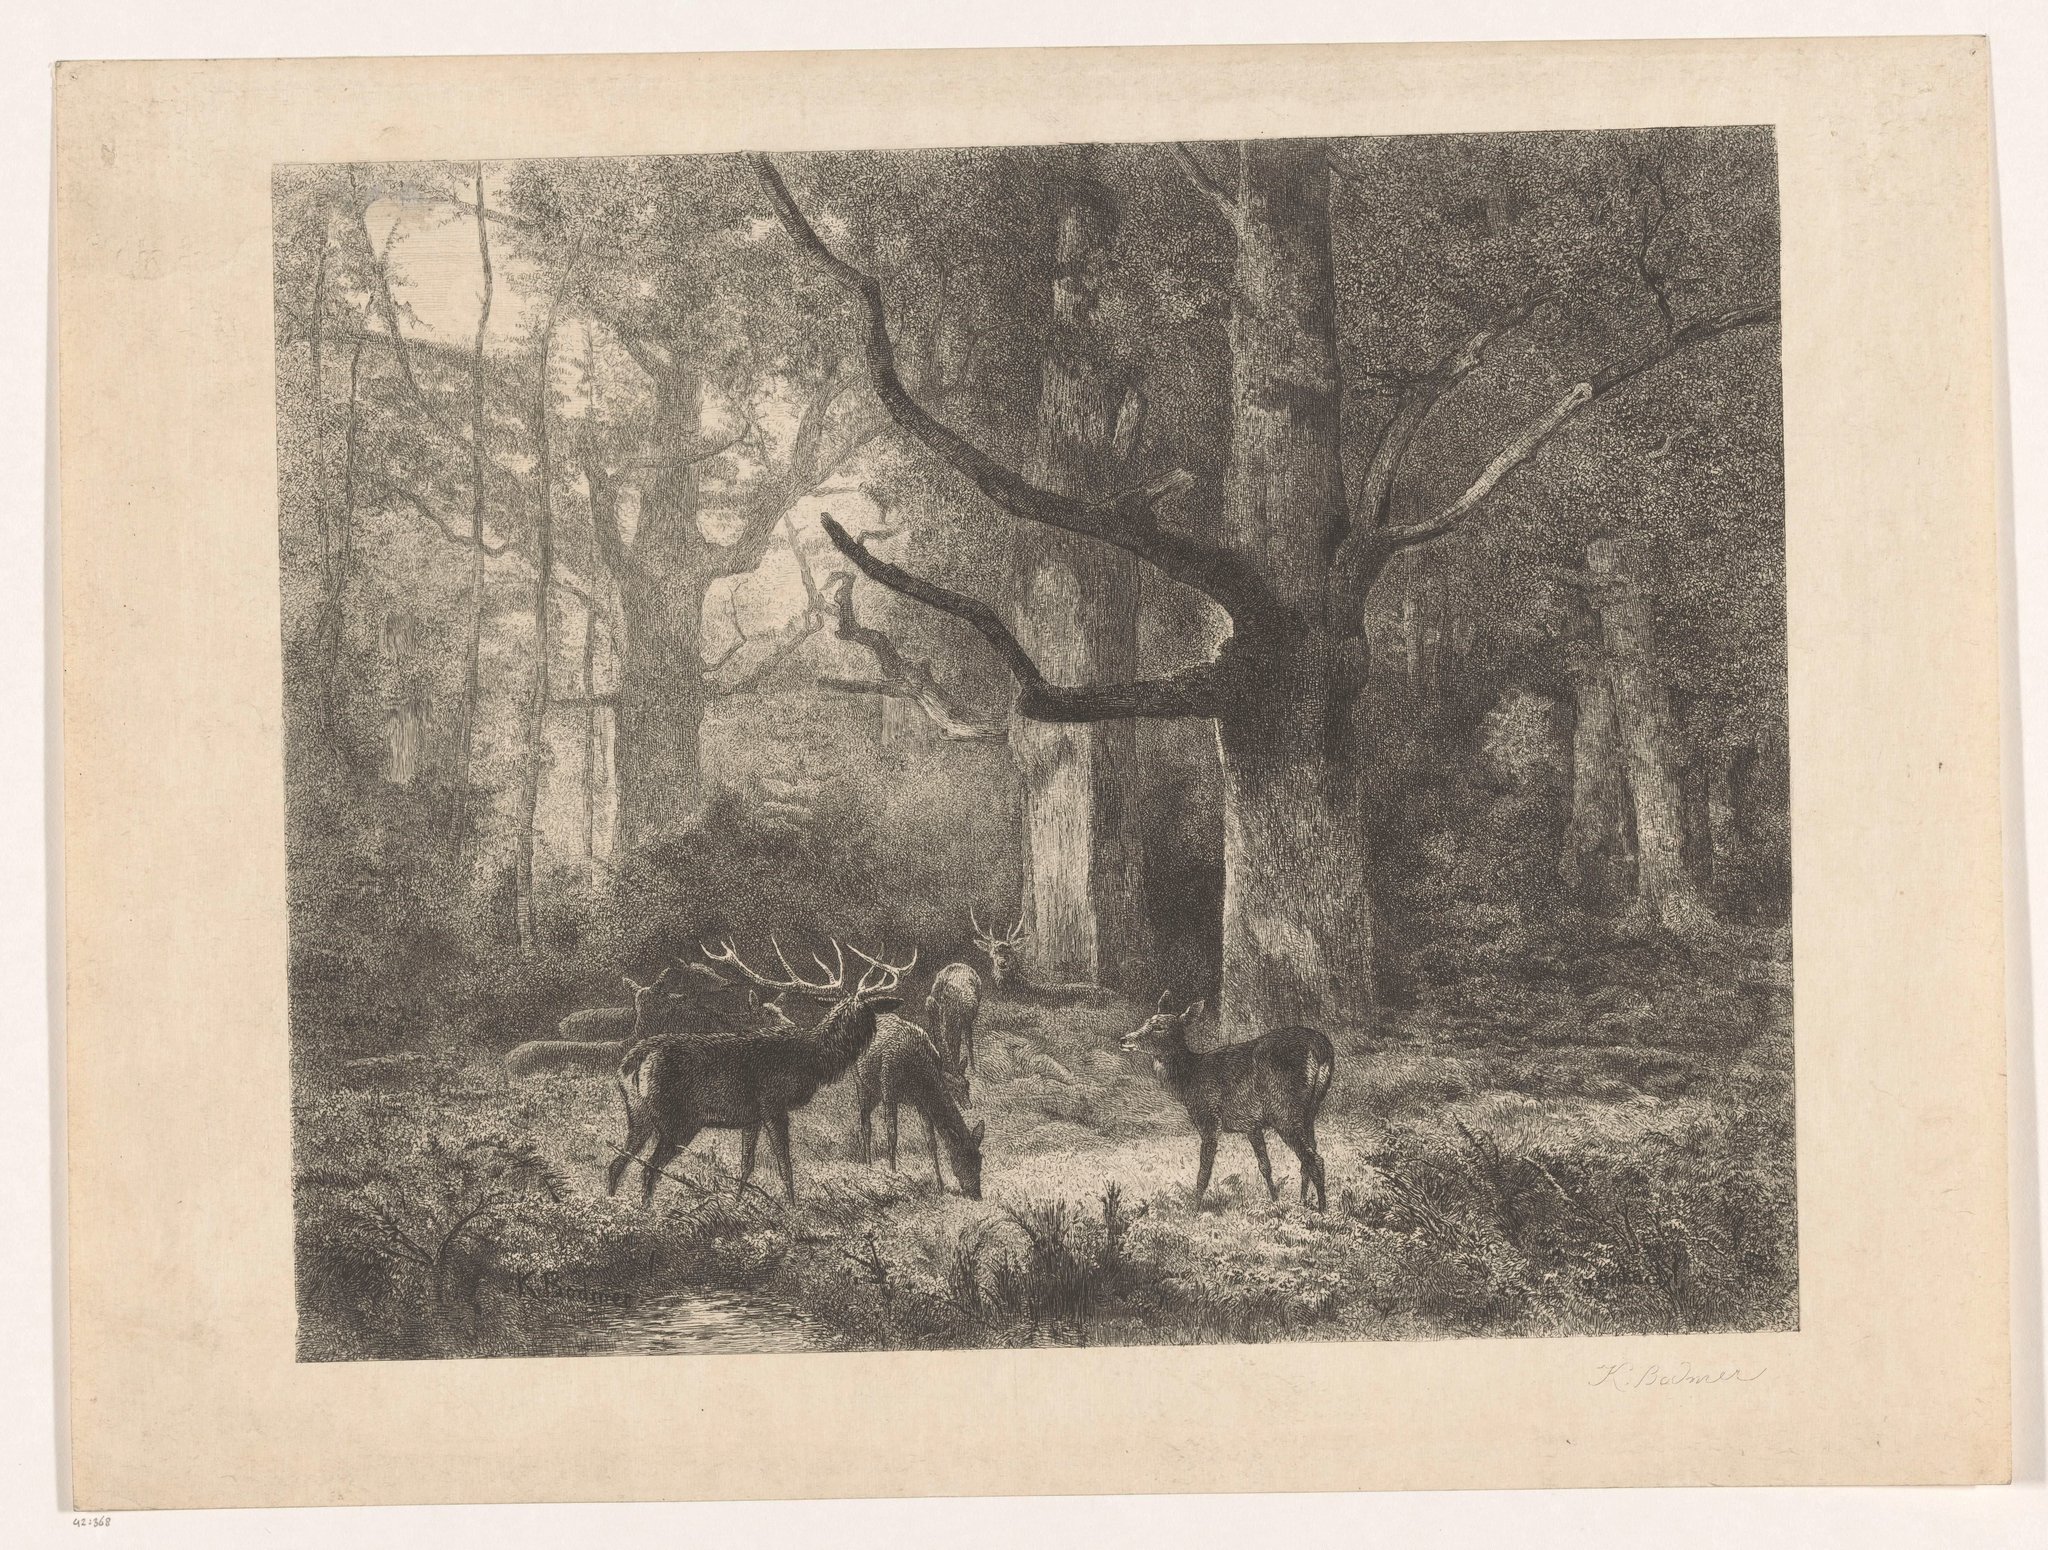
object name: print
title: Herten in een bos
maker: karl bodmer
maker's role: draughtsman, painter, print maker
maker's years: 1809-1893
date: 1822-1893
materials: paper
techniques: etching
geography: france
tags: hoofed animals: deer, forest, wood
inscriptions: collector's mark: Lugt 2228, collector's mark: Lugt 2228